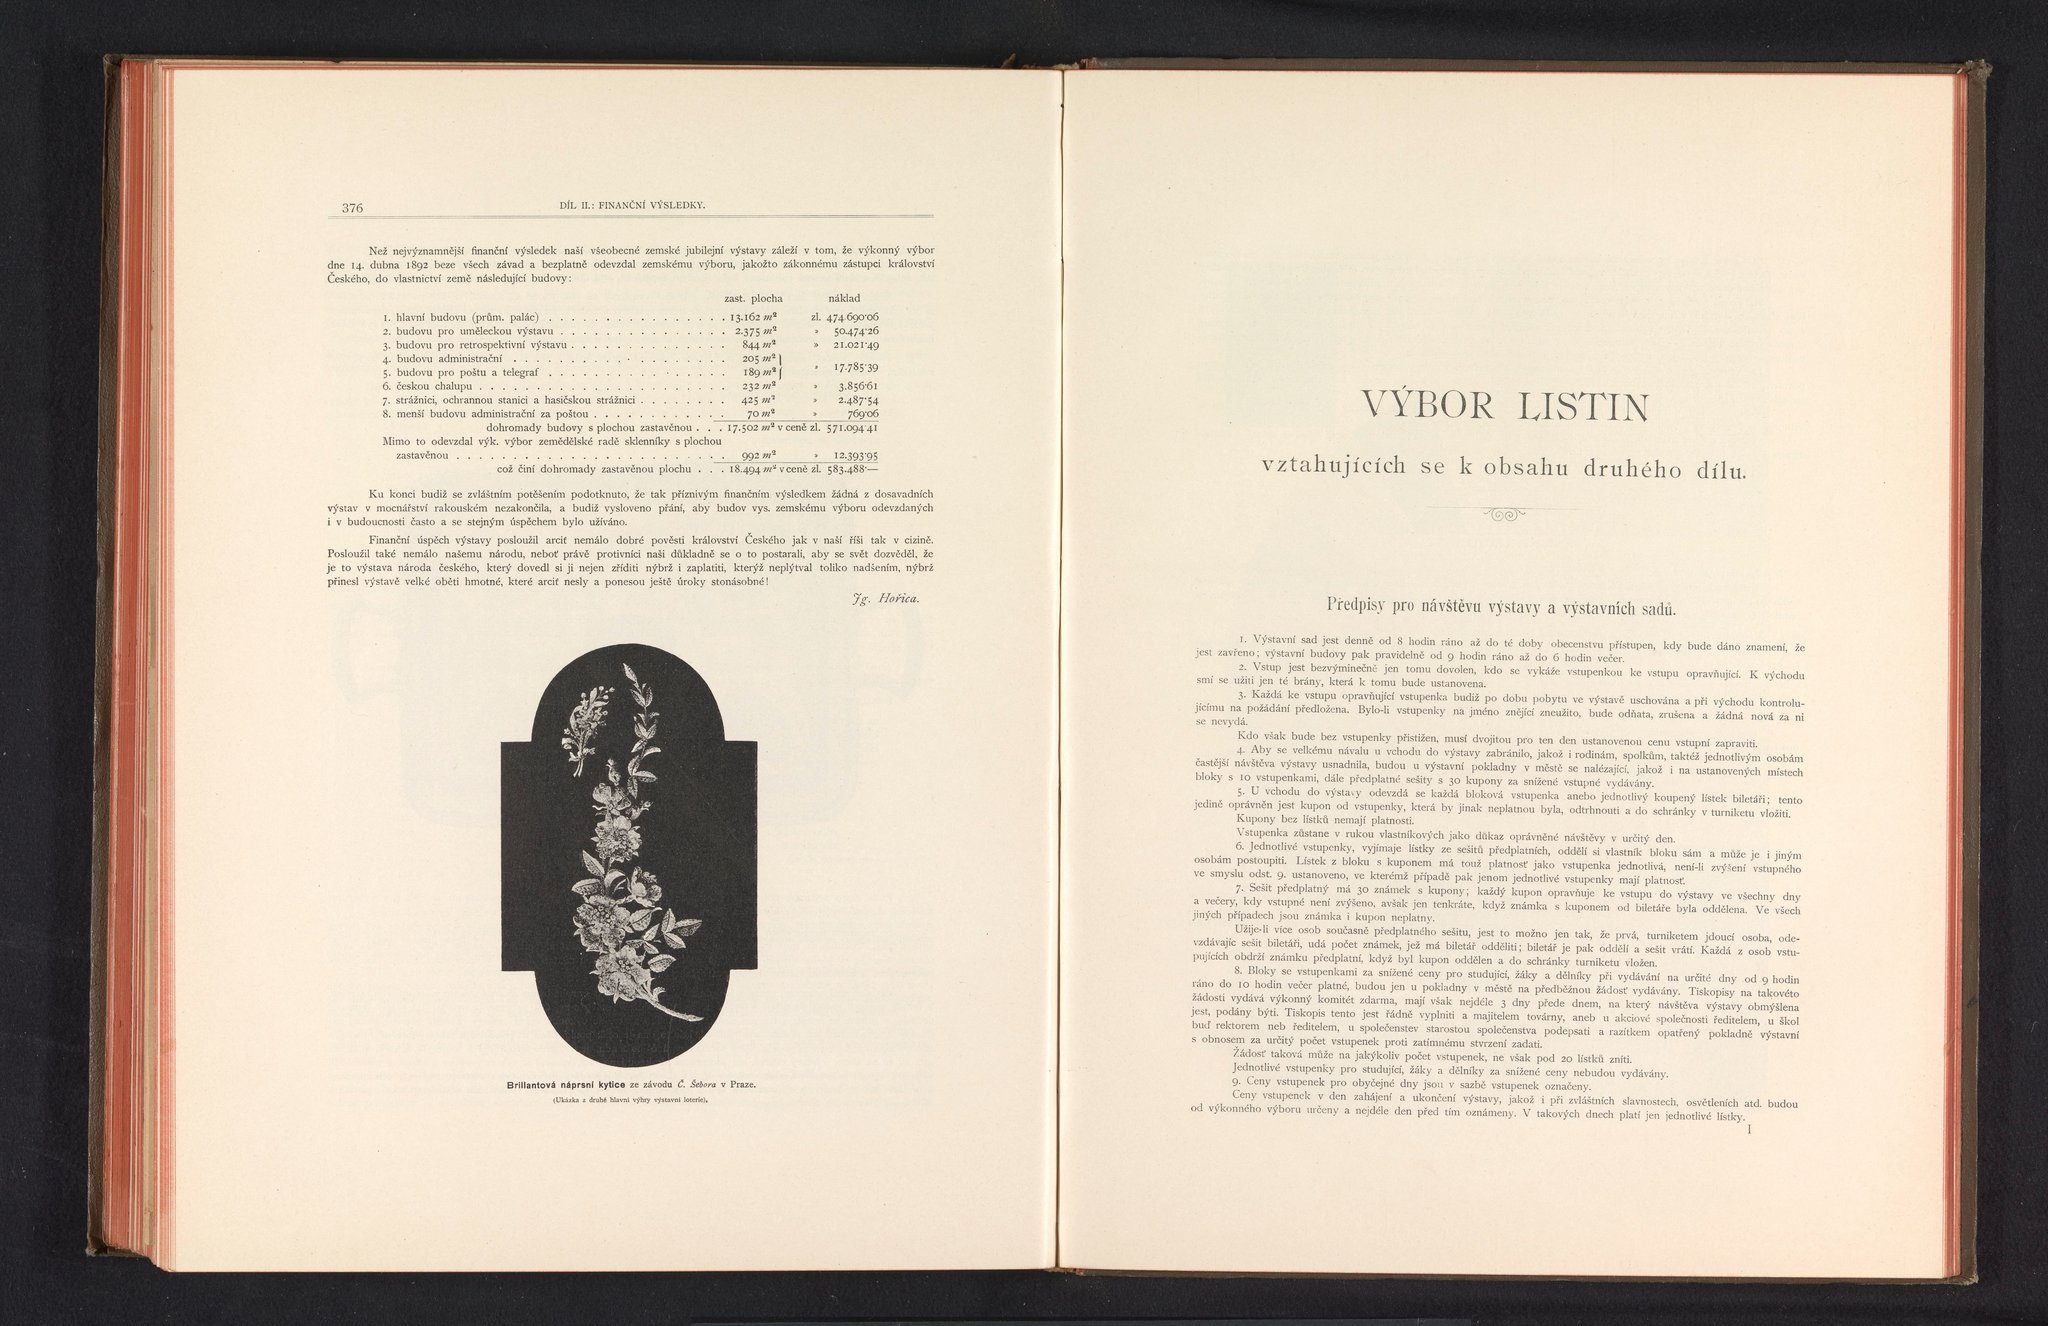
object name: photomechanical print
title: Brillantová náprsní kytice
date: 1891-1893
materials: paper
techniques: autotype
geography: prague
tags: ornaments, jewels